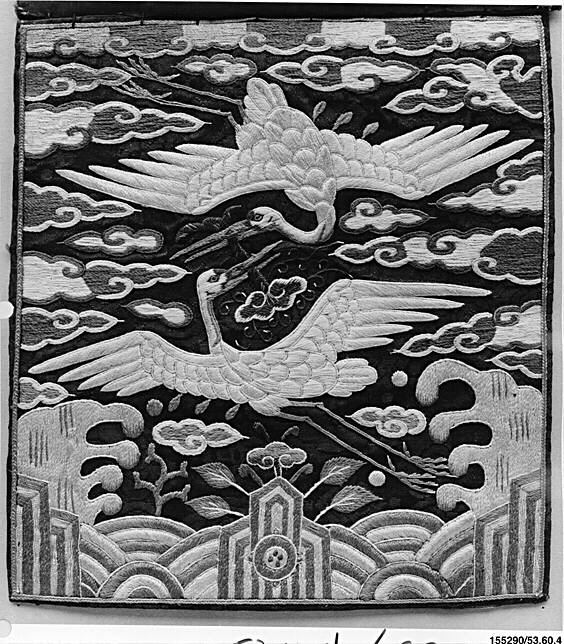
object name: rank badge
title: Rank Badge with Decoration of Two Cranes among Clouds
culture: korean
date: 1801-1900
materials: silk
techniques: damask, embroidery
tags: cranes